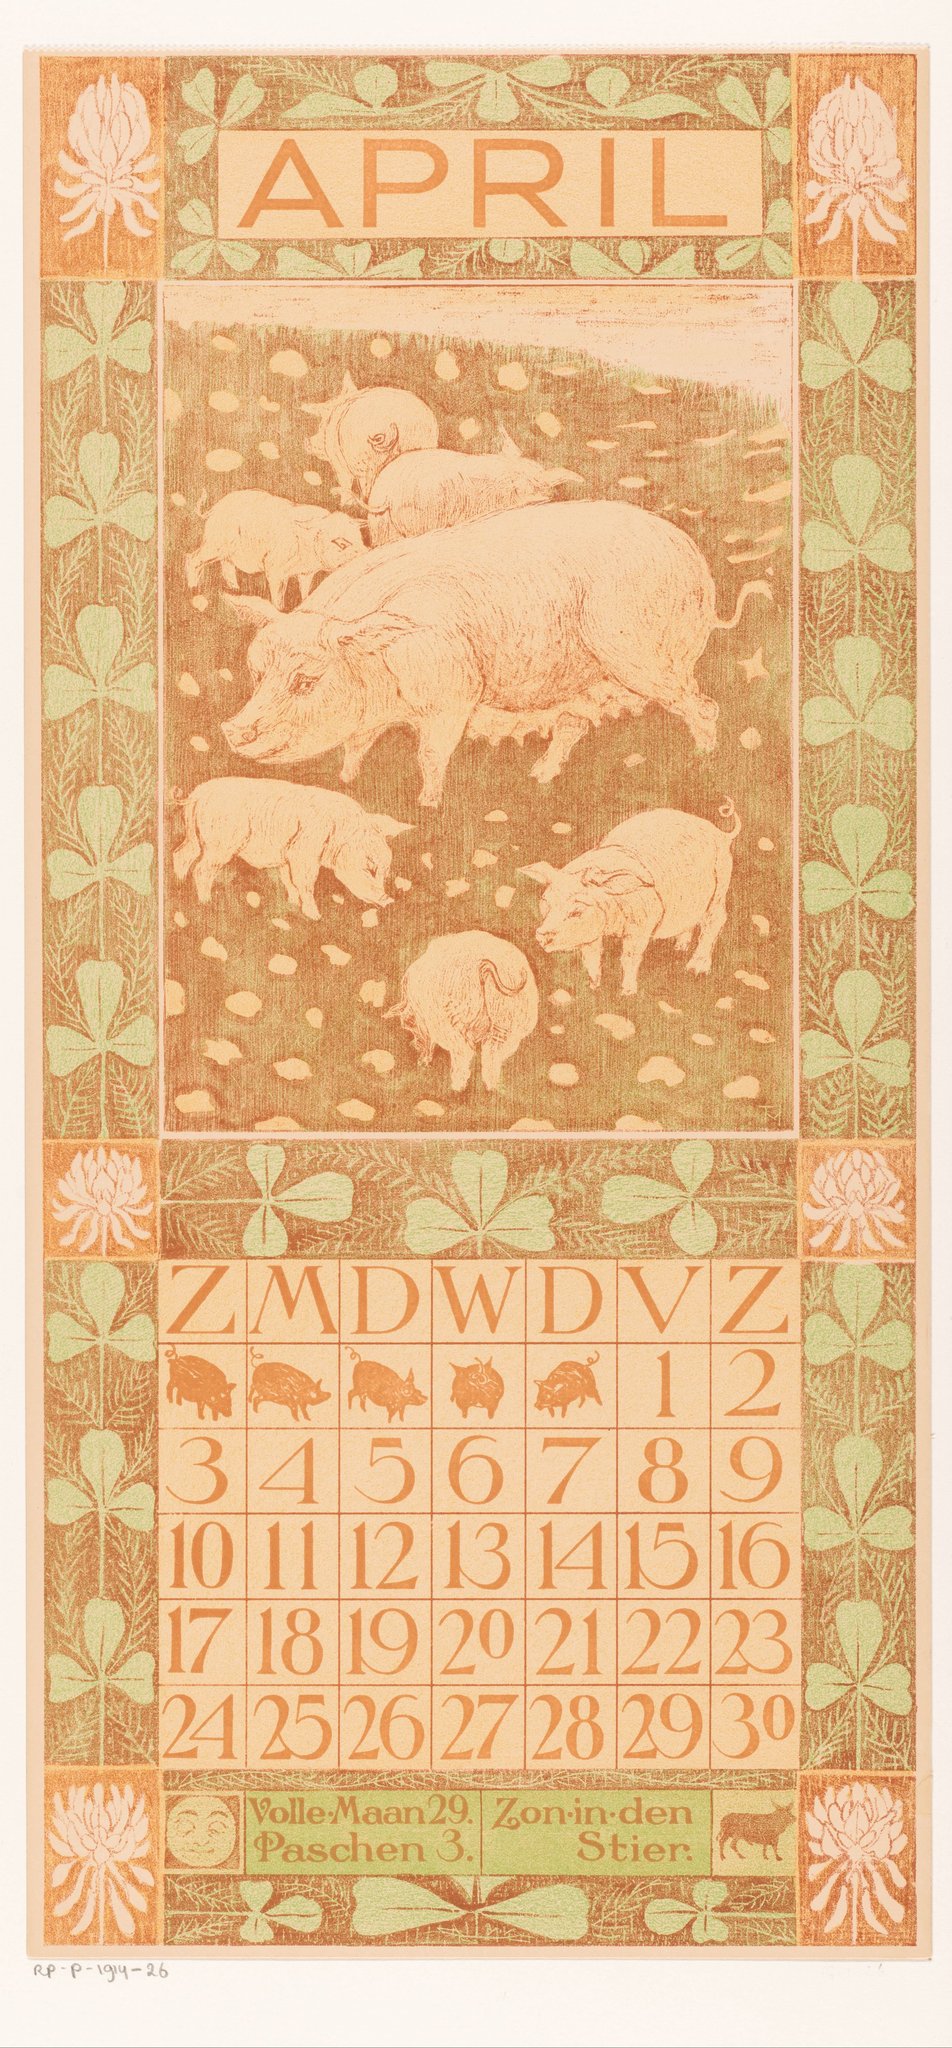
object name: print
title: Kalender 1904 12 lithografien door Th. v. Hoytema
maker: theo van hoytema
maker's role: draughtsman, painter, print maker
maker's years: 1863-1917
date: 1903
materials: paper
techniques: lithograph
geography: hilversum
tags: pig, taurus (zodiacal sign of april), full moon represented as face, plants and herbs: clover, piglet, suckling pig, april ~ other concepts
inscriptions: collector's mark: Lugt 2228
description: Een varken en zes biggen lopen in een weide. In de ornamentrand klaverblad en bloemen. Onder de data een volle maan en het sterrenbeeld Stier. Bovenaan het blad een scheurlijn.